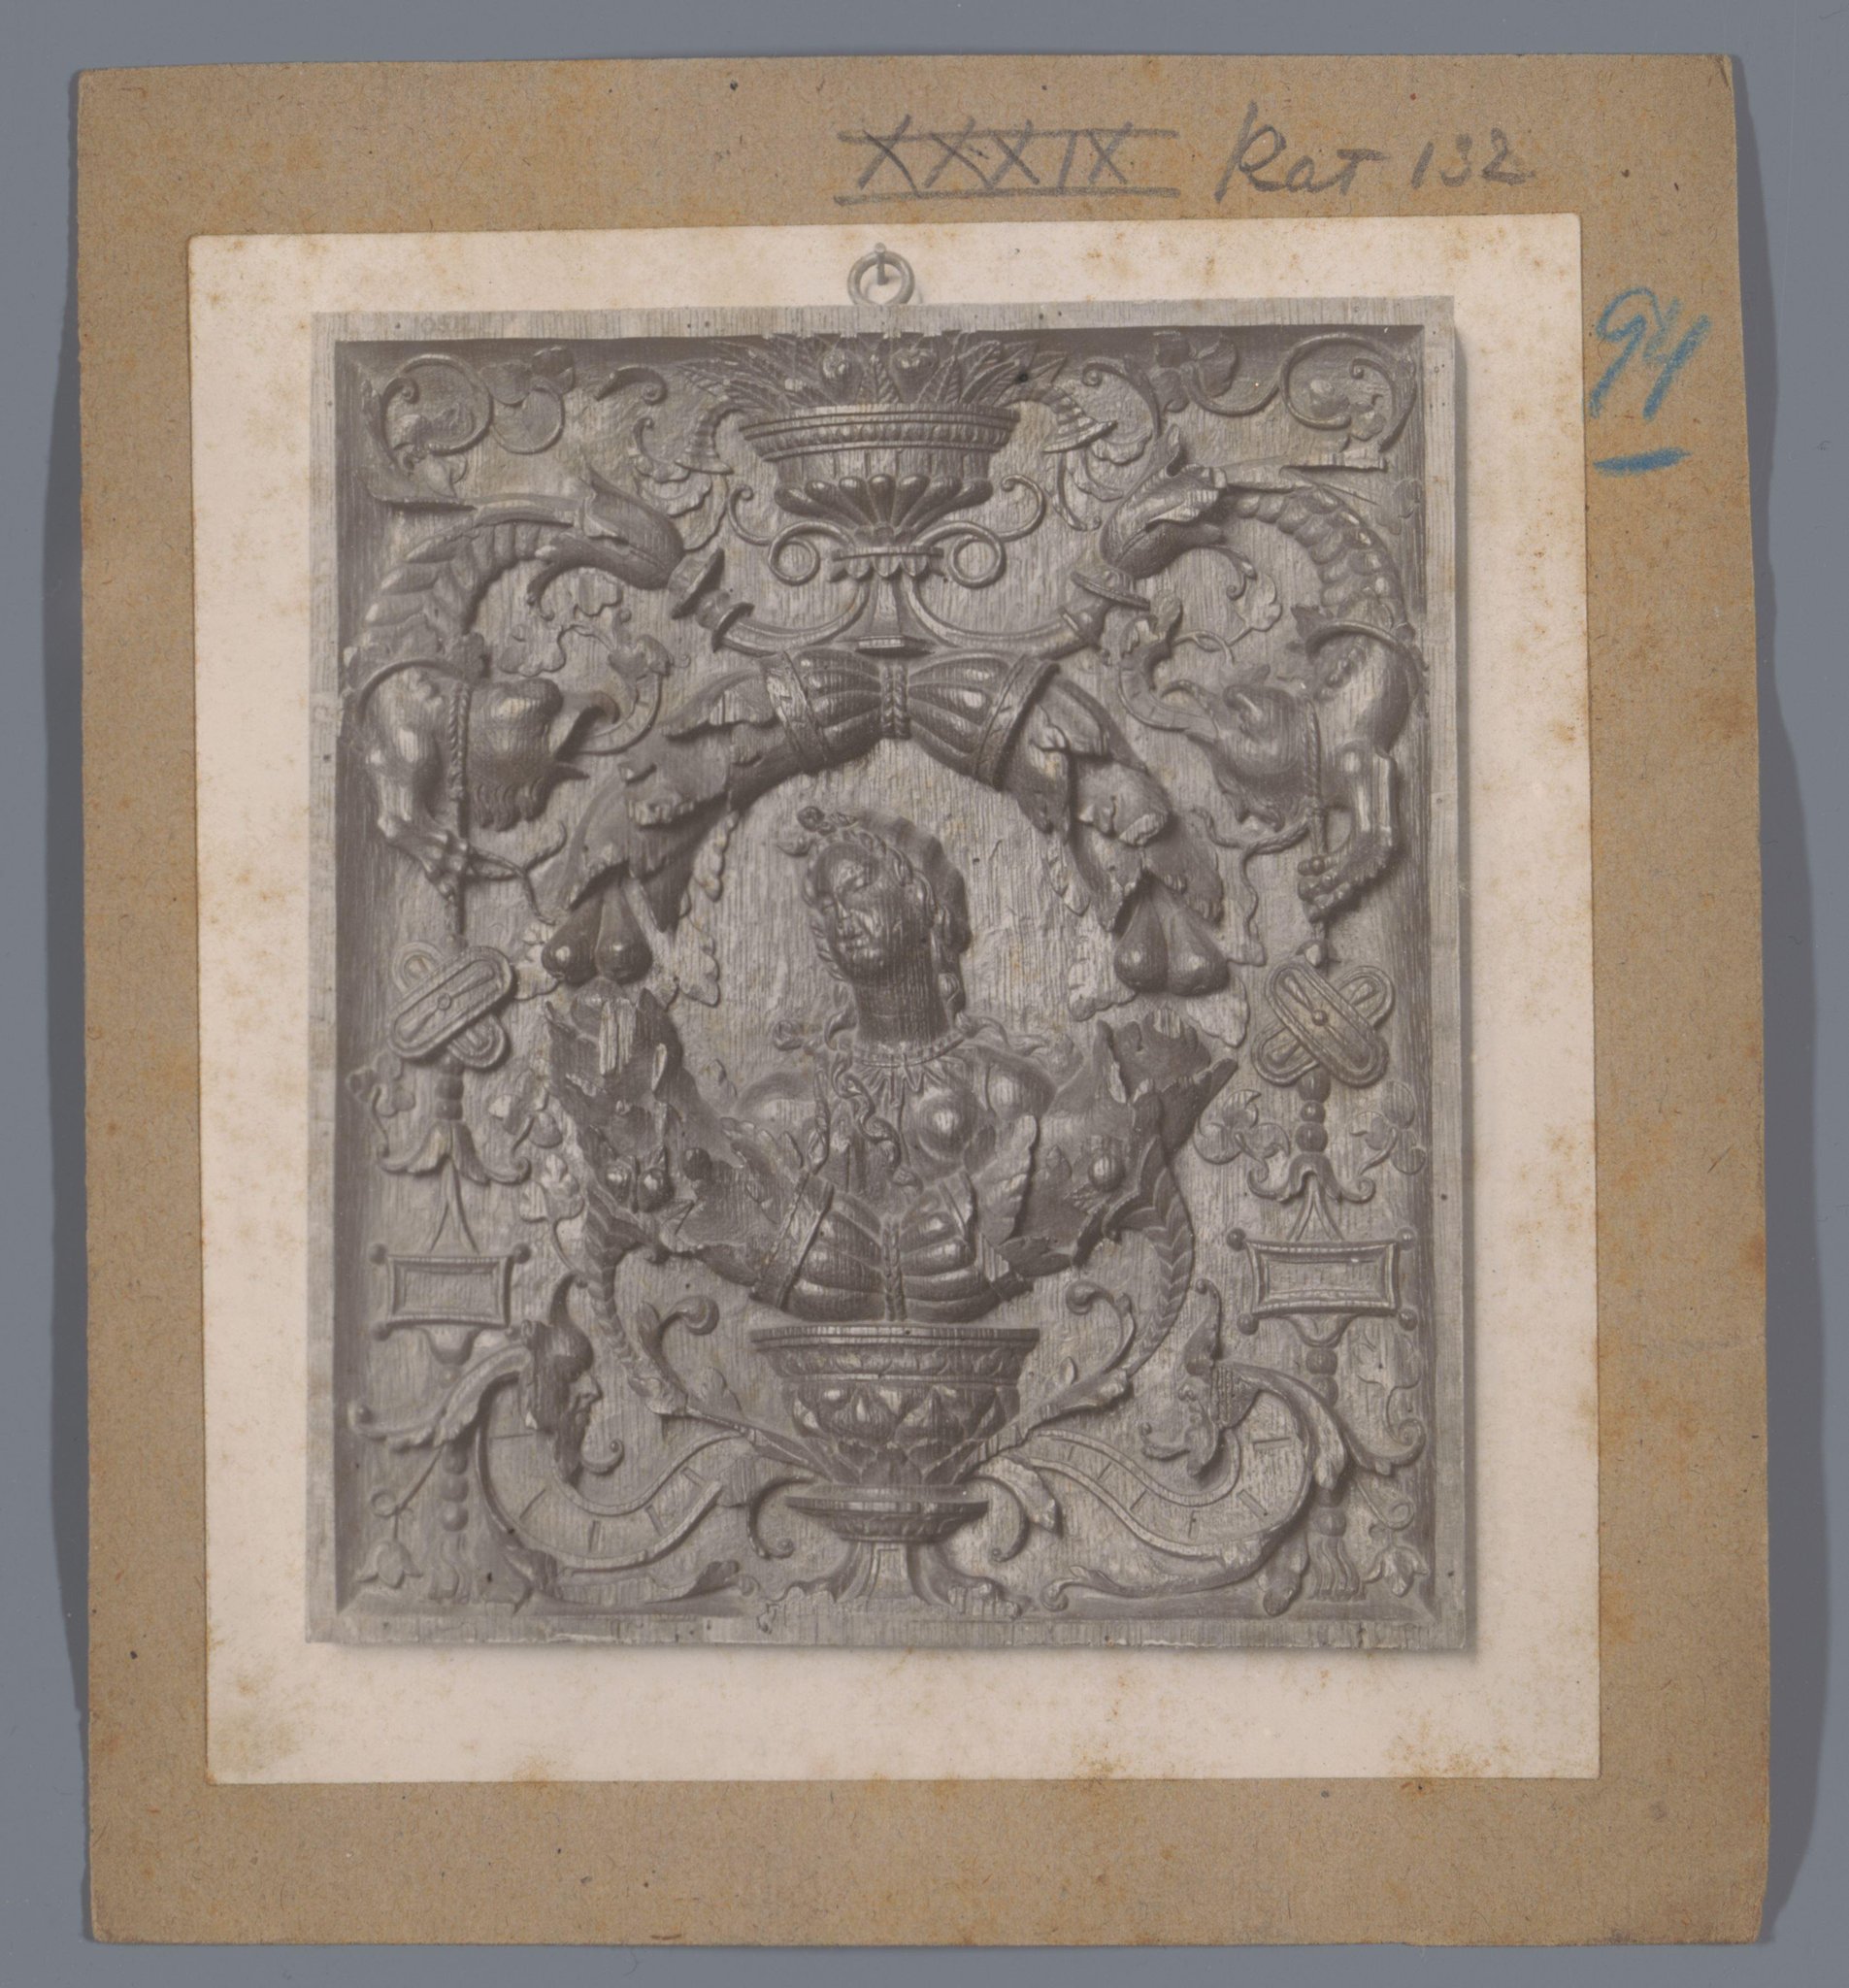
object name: photograph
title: Houten reliëf gedecoreerd met een portret, vazen en fantasiewezens (vermoedelijk) in het Rijksmuseum te Amsterdam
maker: Anonymous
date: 1875-1900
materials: photographic support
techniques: matte daylight collodion silver print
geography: amsterdam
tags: sculpture (+ relief ~ sculpture)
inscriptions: number: ‘XXXIX Kat 132 94’, collector's mark: ‘Kunstnijverheidschool Quellinus Amsterdam Frans Halsstraat 14.’, collector's mark: ‘Instituut voor kunst-nijverheidsonderwijs Gabriël Metsustraat No. 16, Amsterdam’